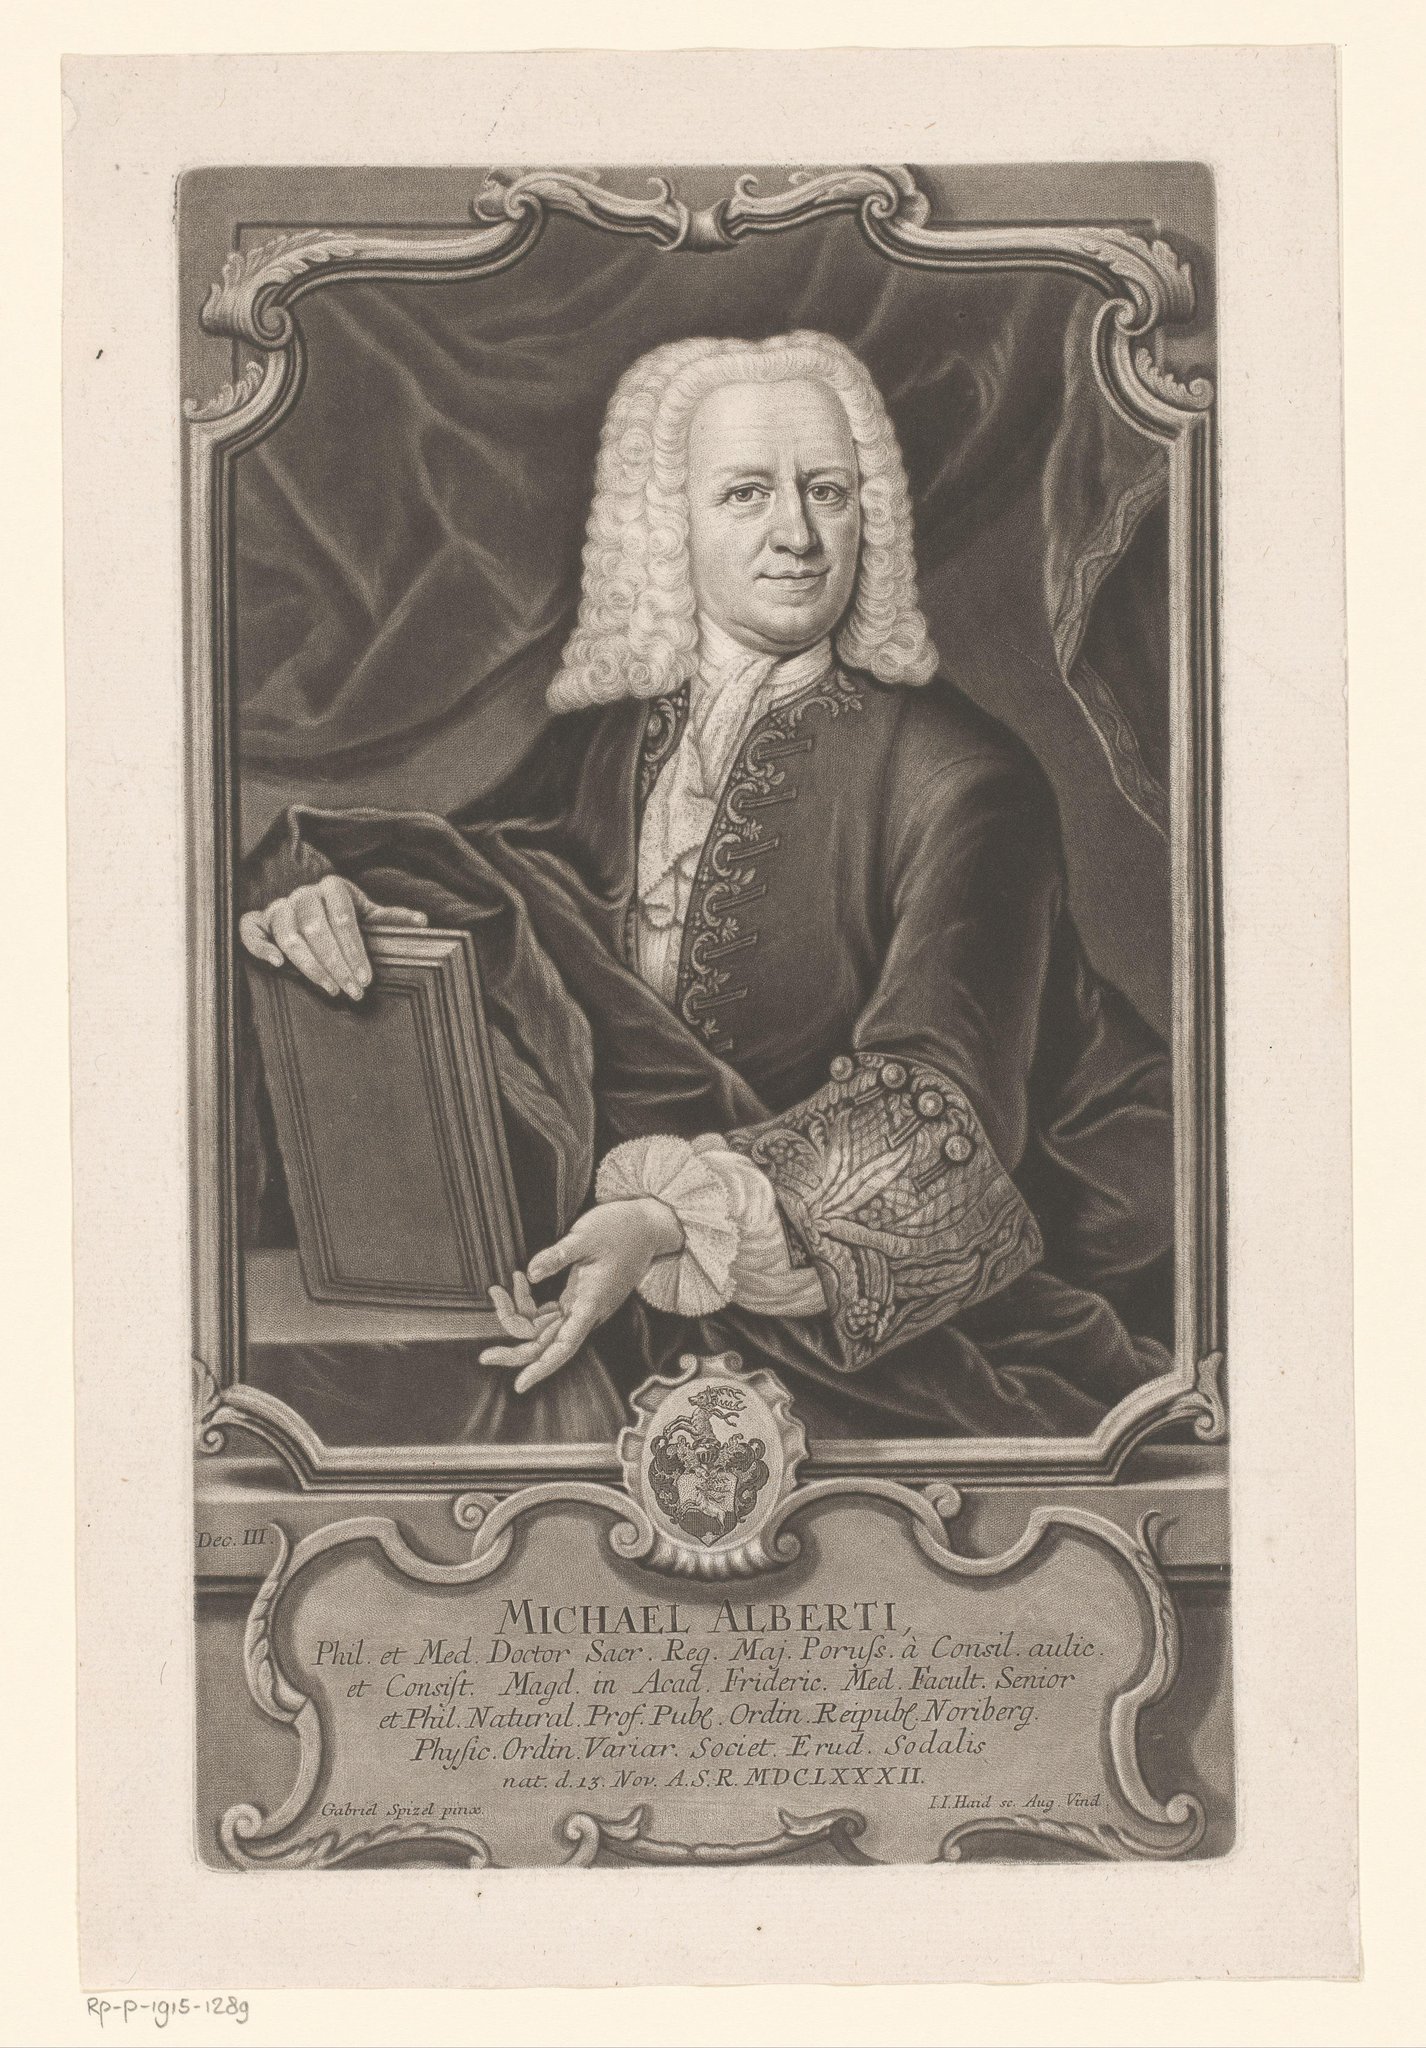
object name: print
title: Portret van Michael Alberti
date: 1714-1757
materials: paper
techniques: etching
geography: augsburg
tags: michael alberti, historical persons, book, armorial bearing, heraldry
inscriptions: collector's mark: Lugt 2228